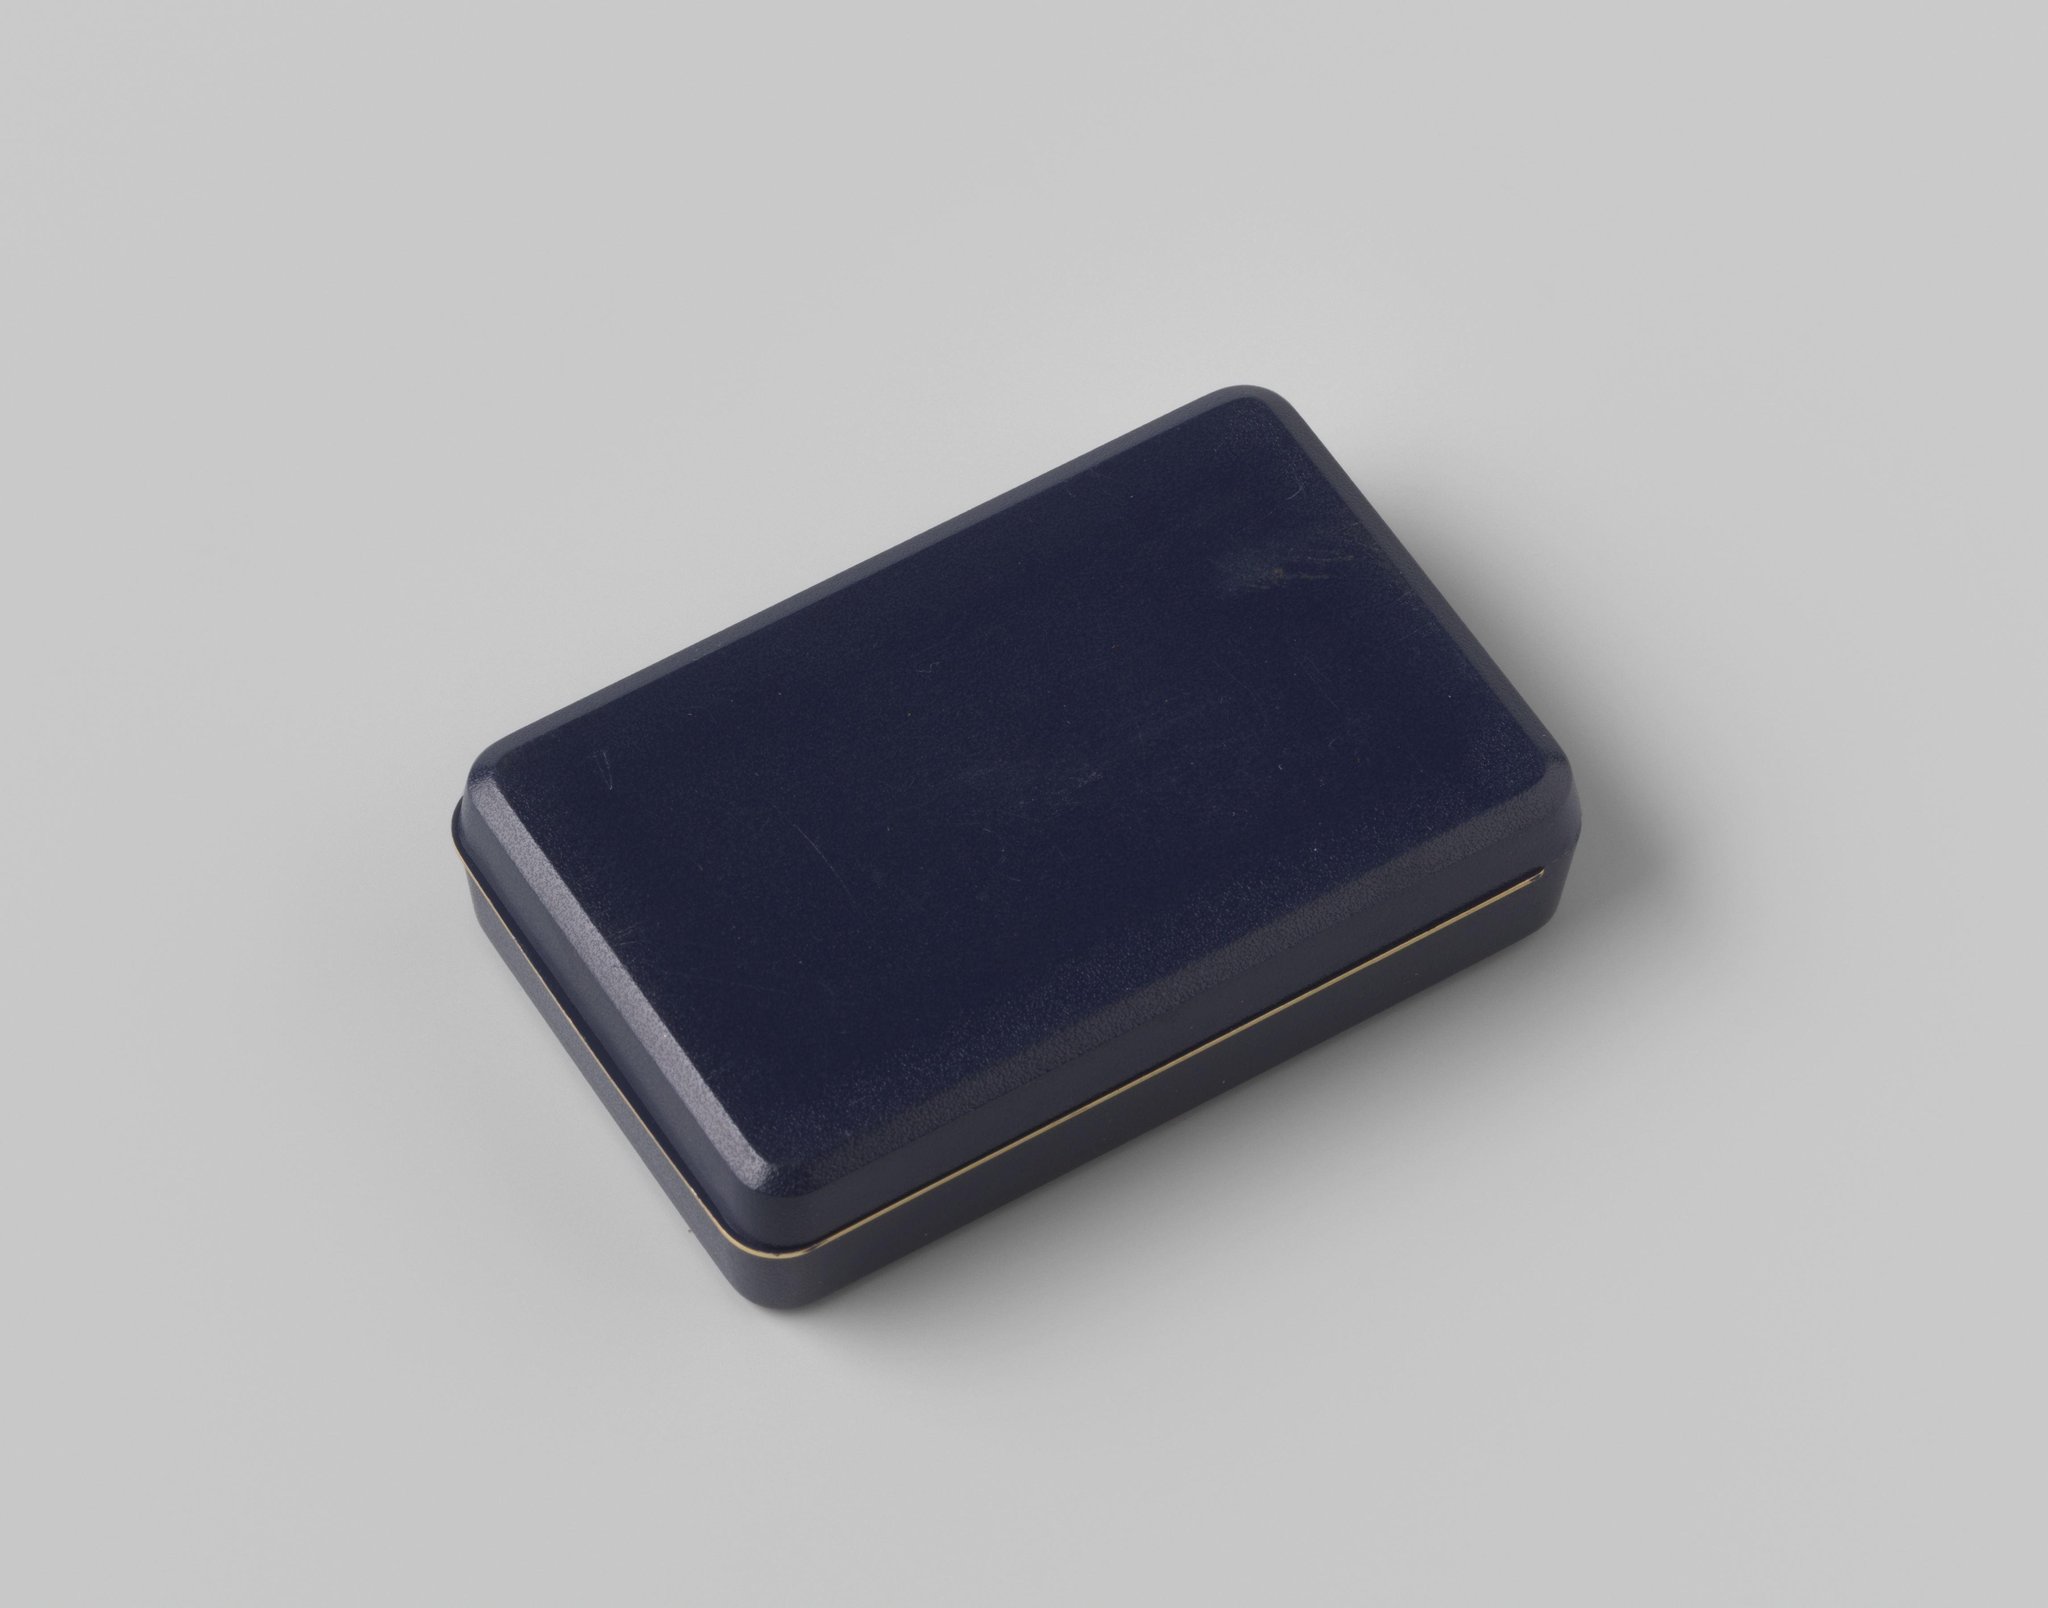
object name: box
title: Doos horend bij een bronzen penning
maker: Anonymous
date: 1970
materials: plastic, velvet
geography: netherlands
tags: the hague, willem drees, netherlands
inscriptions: date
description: Rechthoekig blauw plastic doosje met binnen in deksel: A. van Tol / juwelier, horlogier / ... Den Haag. Binnenkant is bekleedt met blauw fluweel.